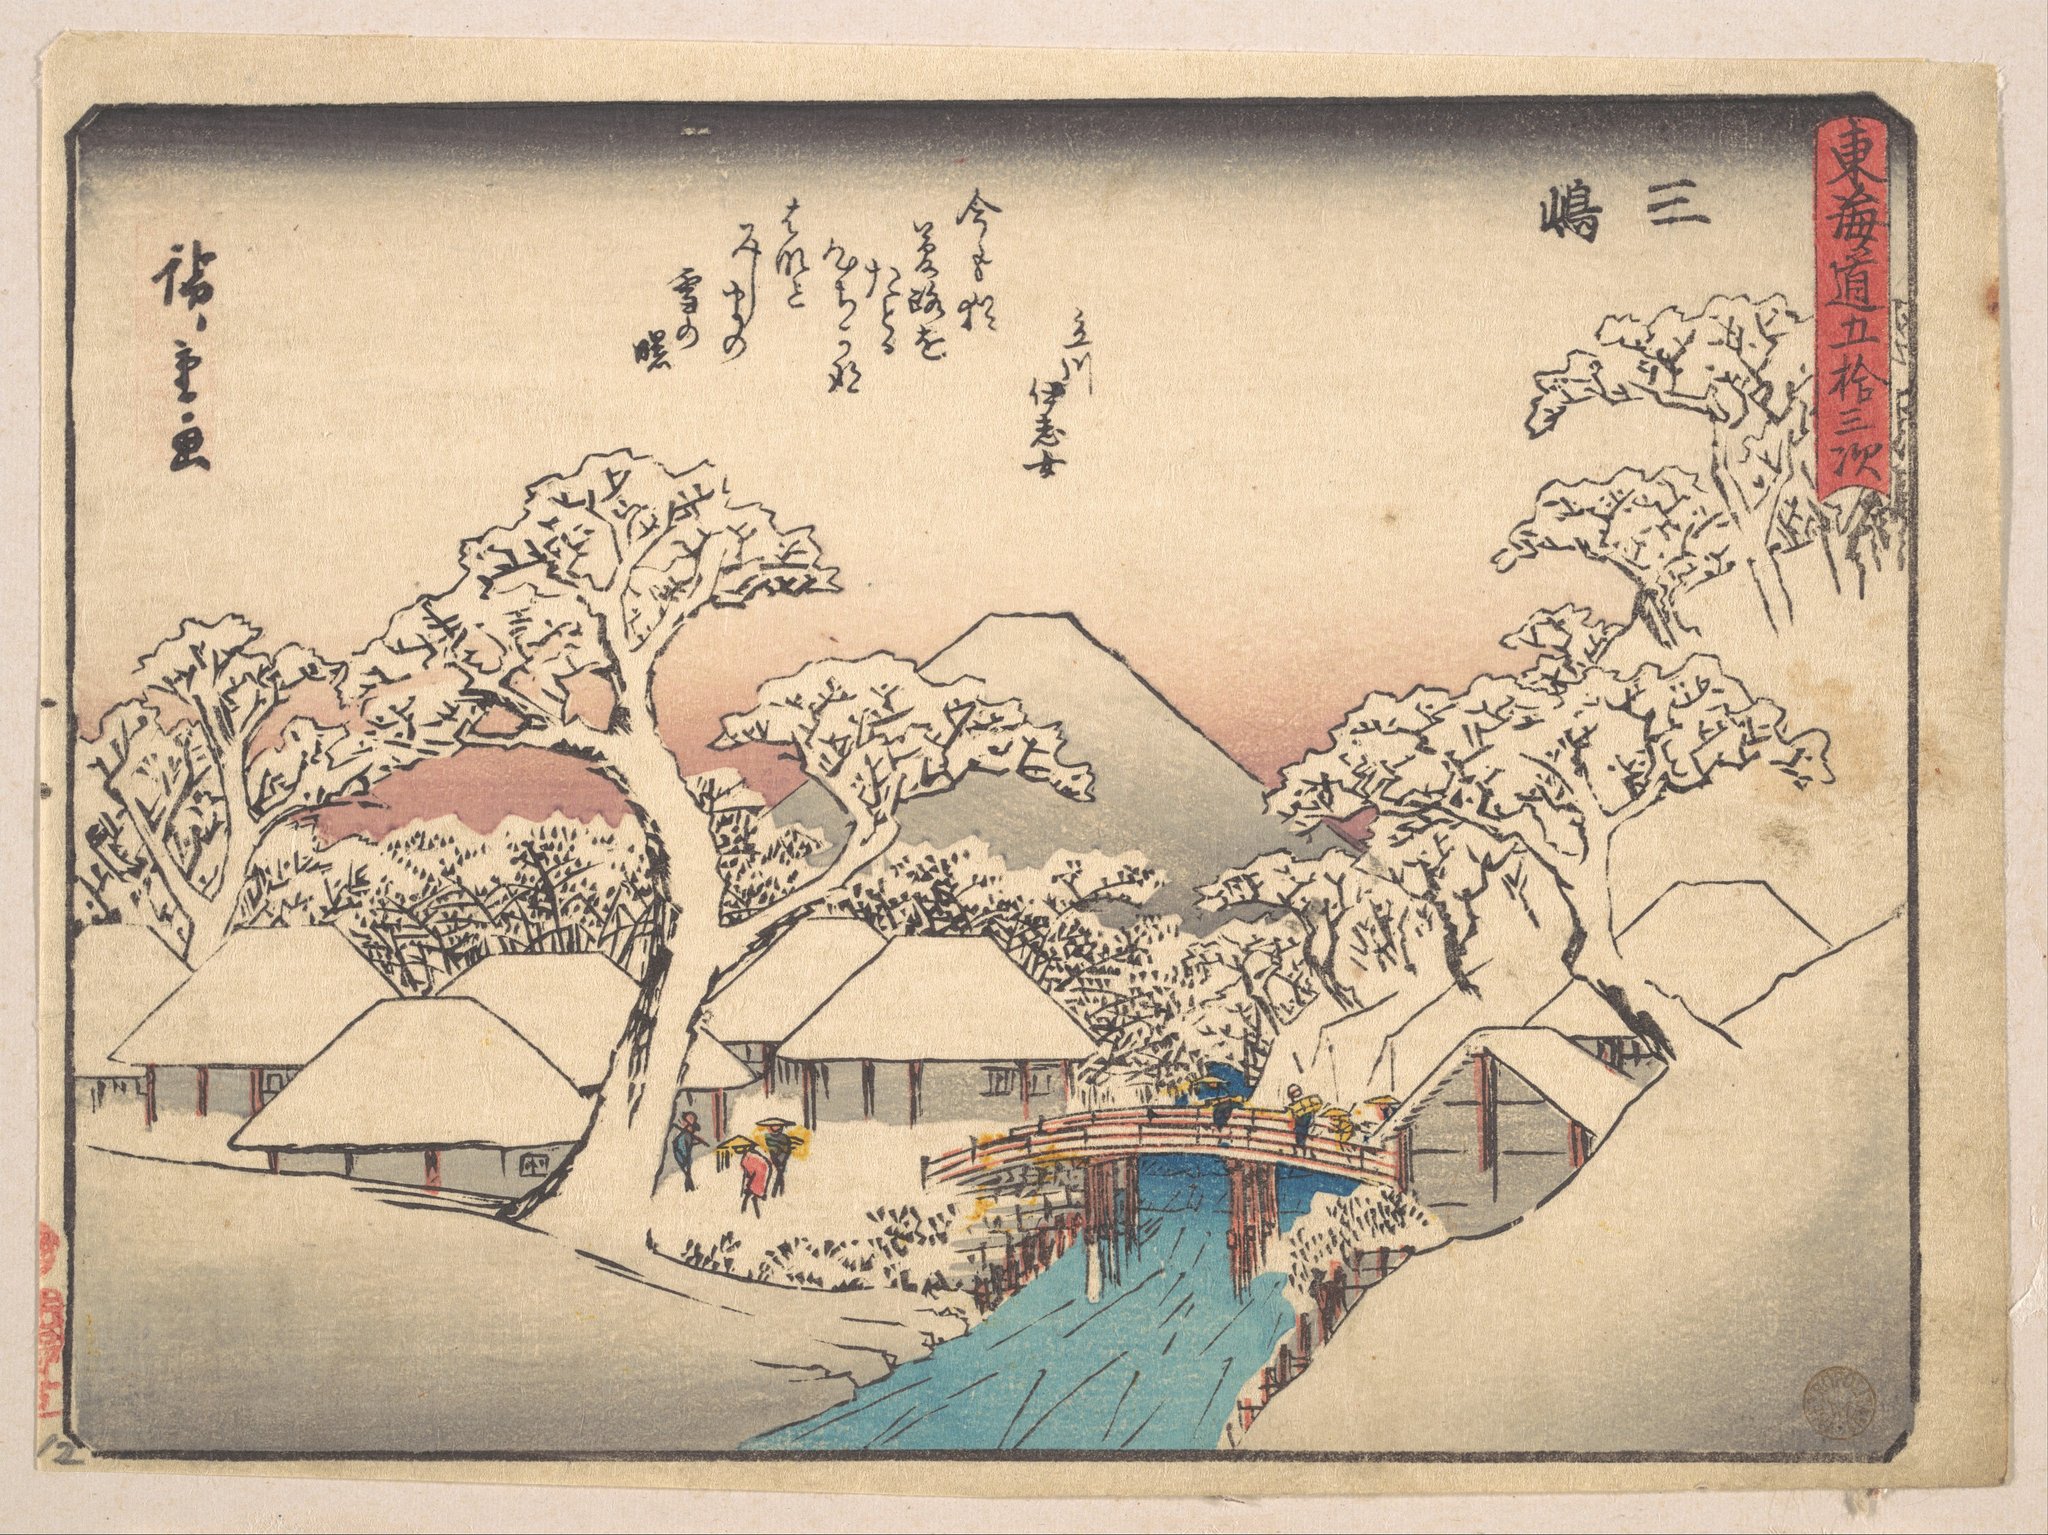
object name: print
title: Mishima, from the series Fifty-three Stations of the Tōkaidō Road (Tōkaidō gojūsan tsugi, Mishima), also known as the Kyōka (Witty Verse) Tōkaidō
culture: japanese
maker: utagawa hiroshige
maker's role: artist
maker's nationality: japanese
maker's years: 1797-1858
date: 1838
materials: ink, paper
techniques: woodblock print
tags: bridges,mountains,trees,snow